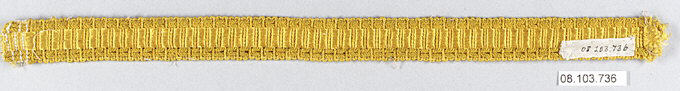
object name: gimp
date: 1834-1866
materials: silk